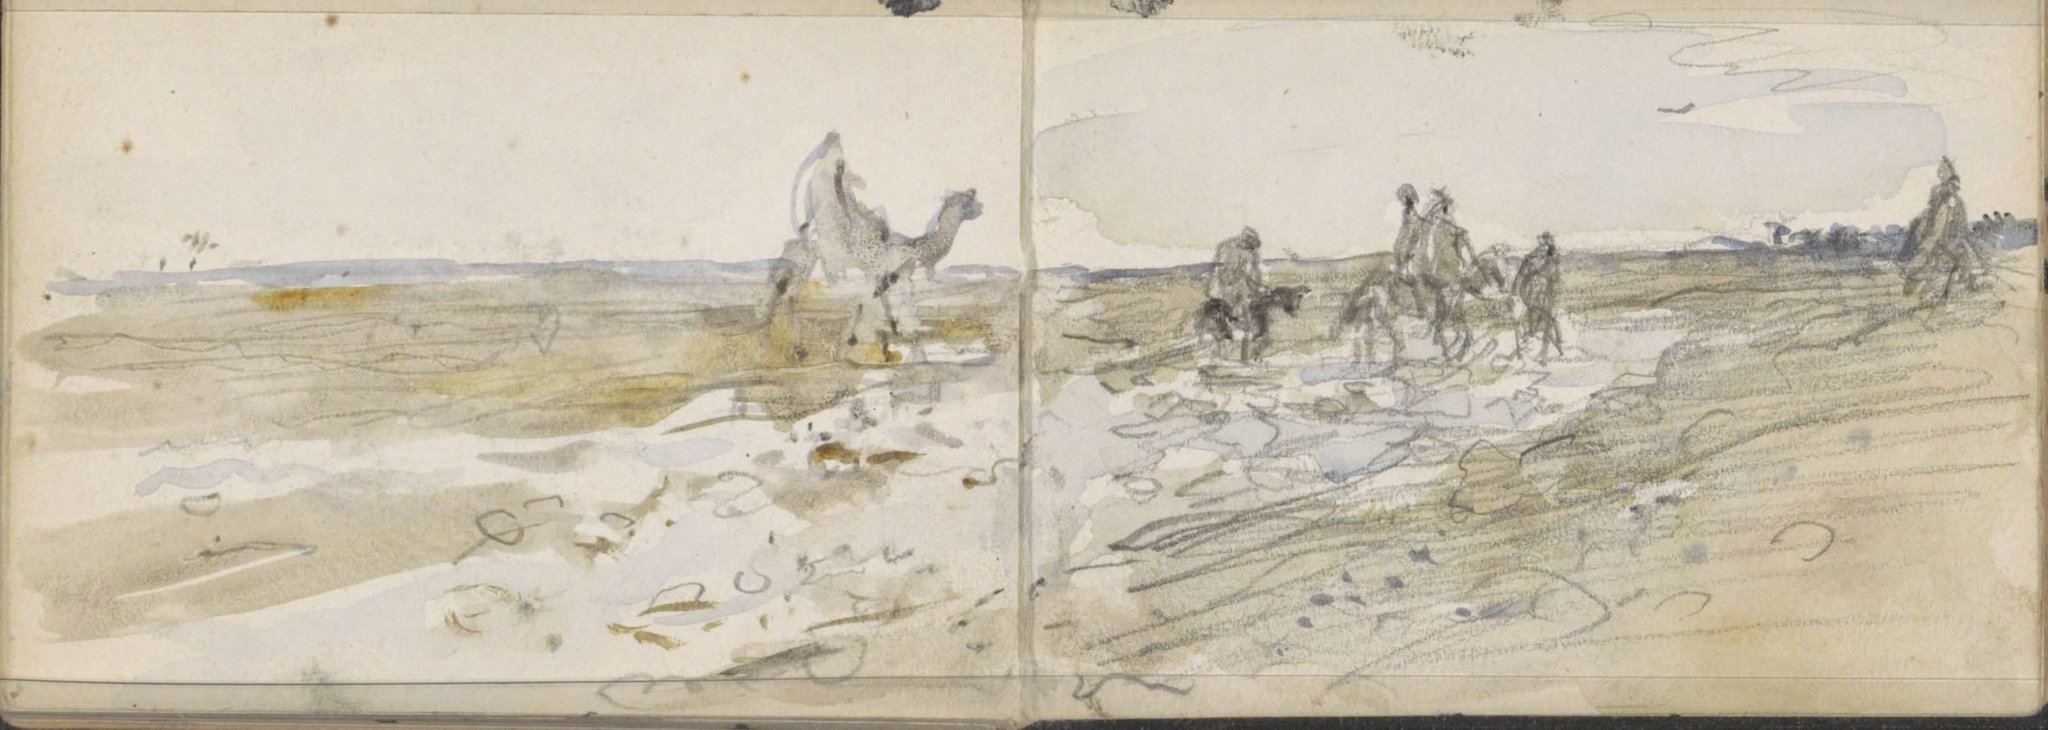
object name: sketchbook leaf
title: Woestijnlandschap met figuren op kamelen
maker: marius bauer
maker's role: draughtsman, print maker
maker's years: 1867-1932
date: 1922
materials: paper, pencil, watercolor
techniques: brush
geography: biskra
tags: hoofed animals: camel, sitting figure, desert, landscapes (+ landscape with figures, staffage)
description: Pagina 60 en 61 uit een schetsboek met 32 bladen.